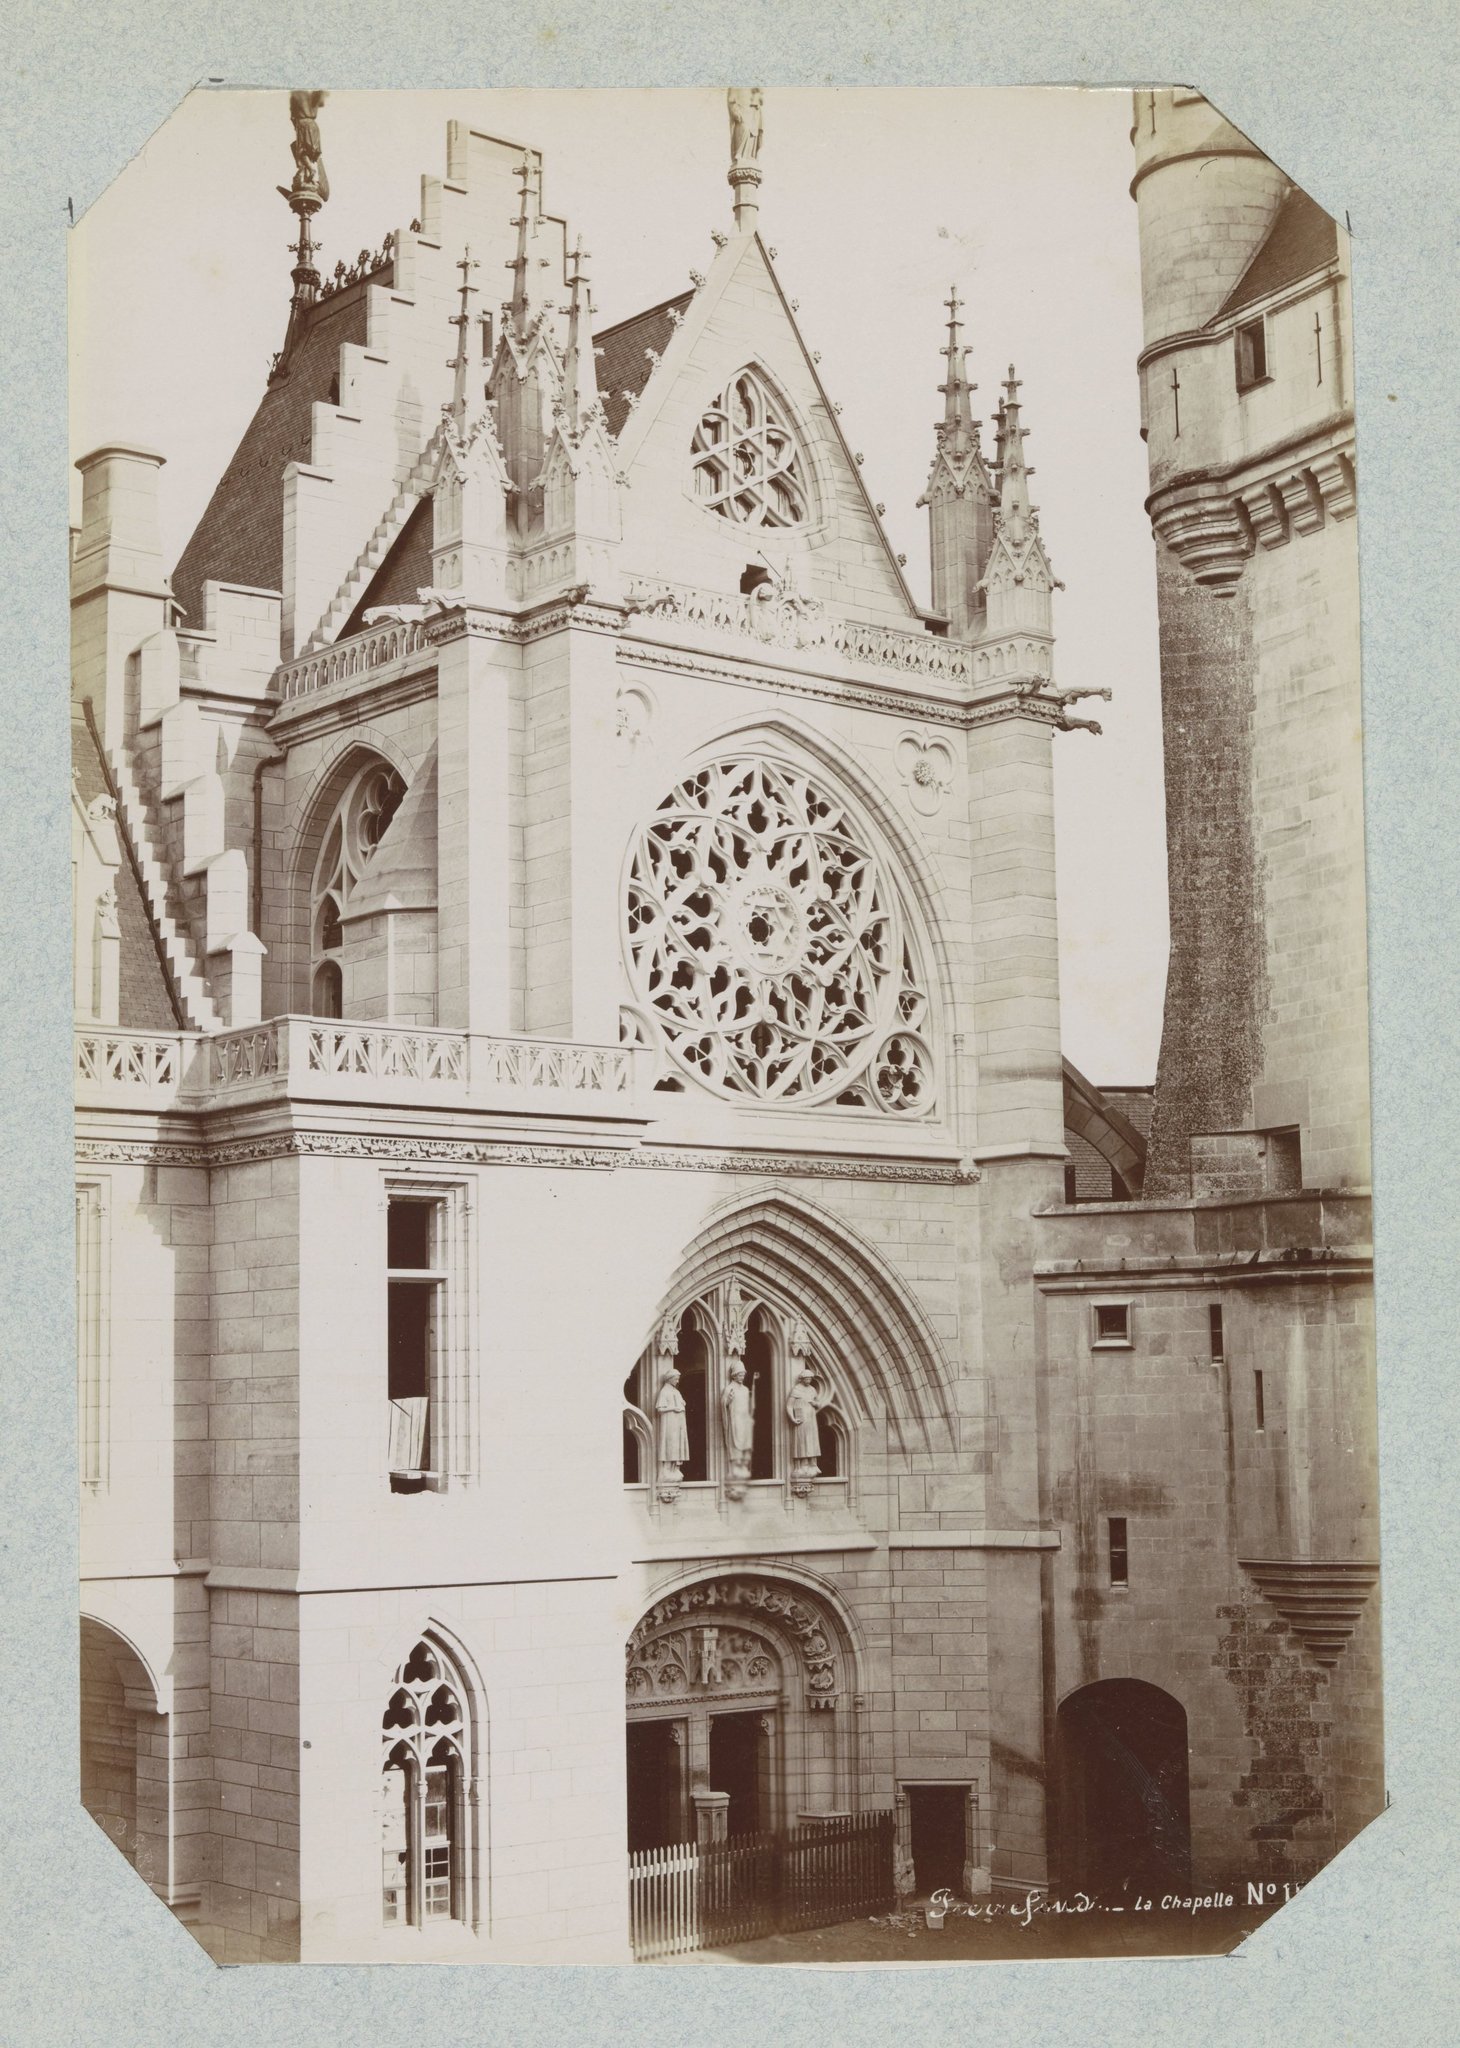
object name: photograph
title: Exterieur van de kapel van het kasteel van Pierrefonds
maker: paul robert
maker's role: fotograaf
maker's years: 1865-1905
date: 1880-1900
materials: photographic support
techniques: albumen print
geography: pierrefonds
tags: parts of church exterior and annexes: portal, church (exterior) - qq - small church, chapel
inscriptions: inscription: ‘Monuments Historiques’, name: ‘[...]bert’, number: ‘[...]’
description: Onderdeel van Fotoalbum met opnames van monumenten in Frankrijk.